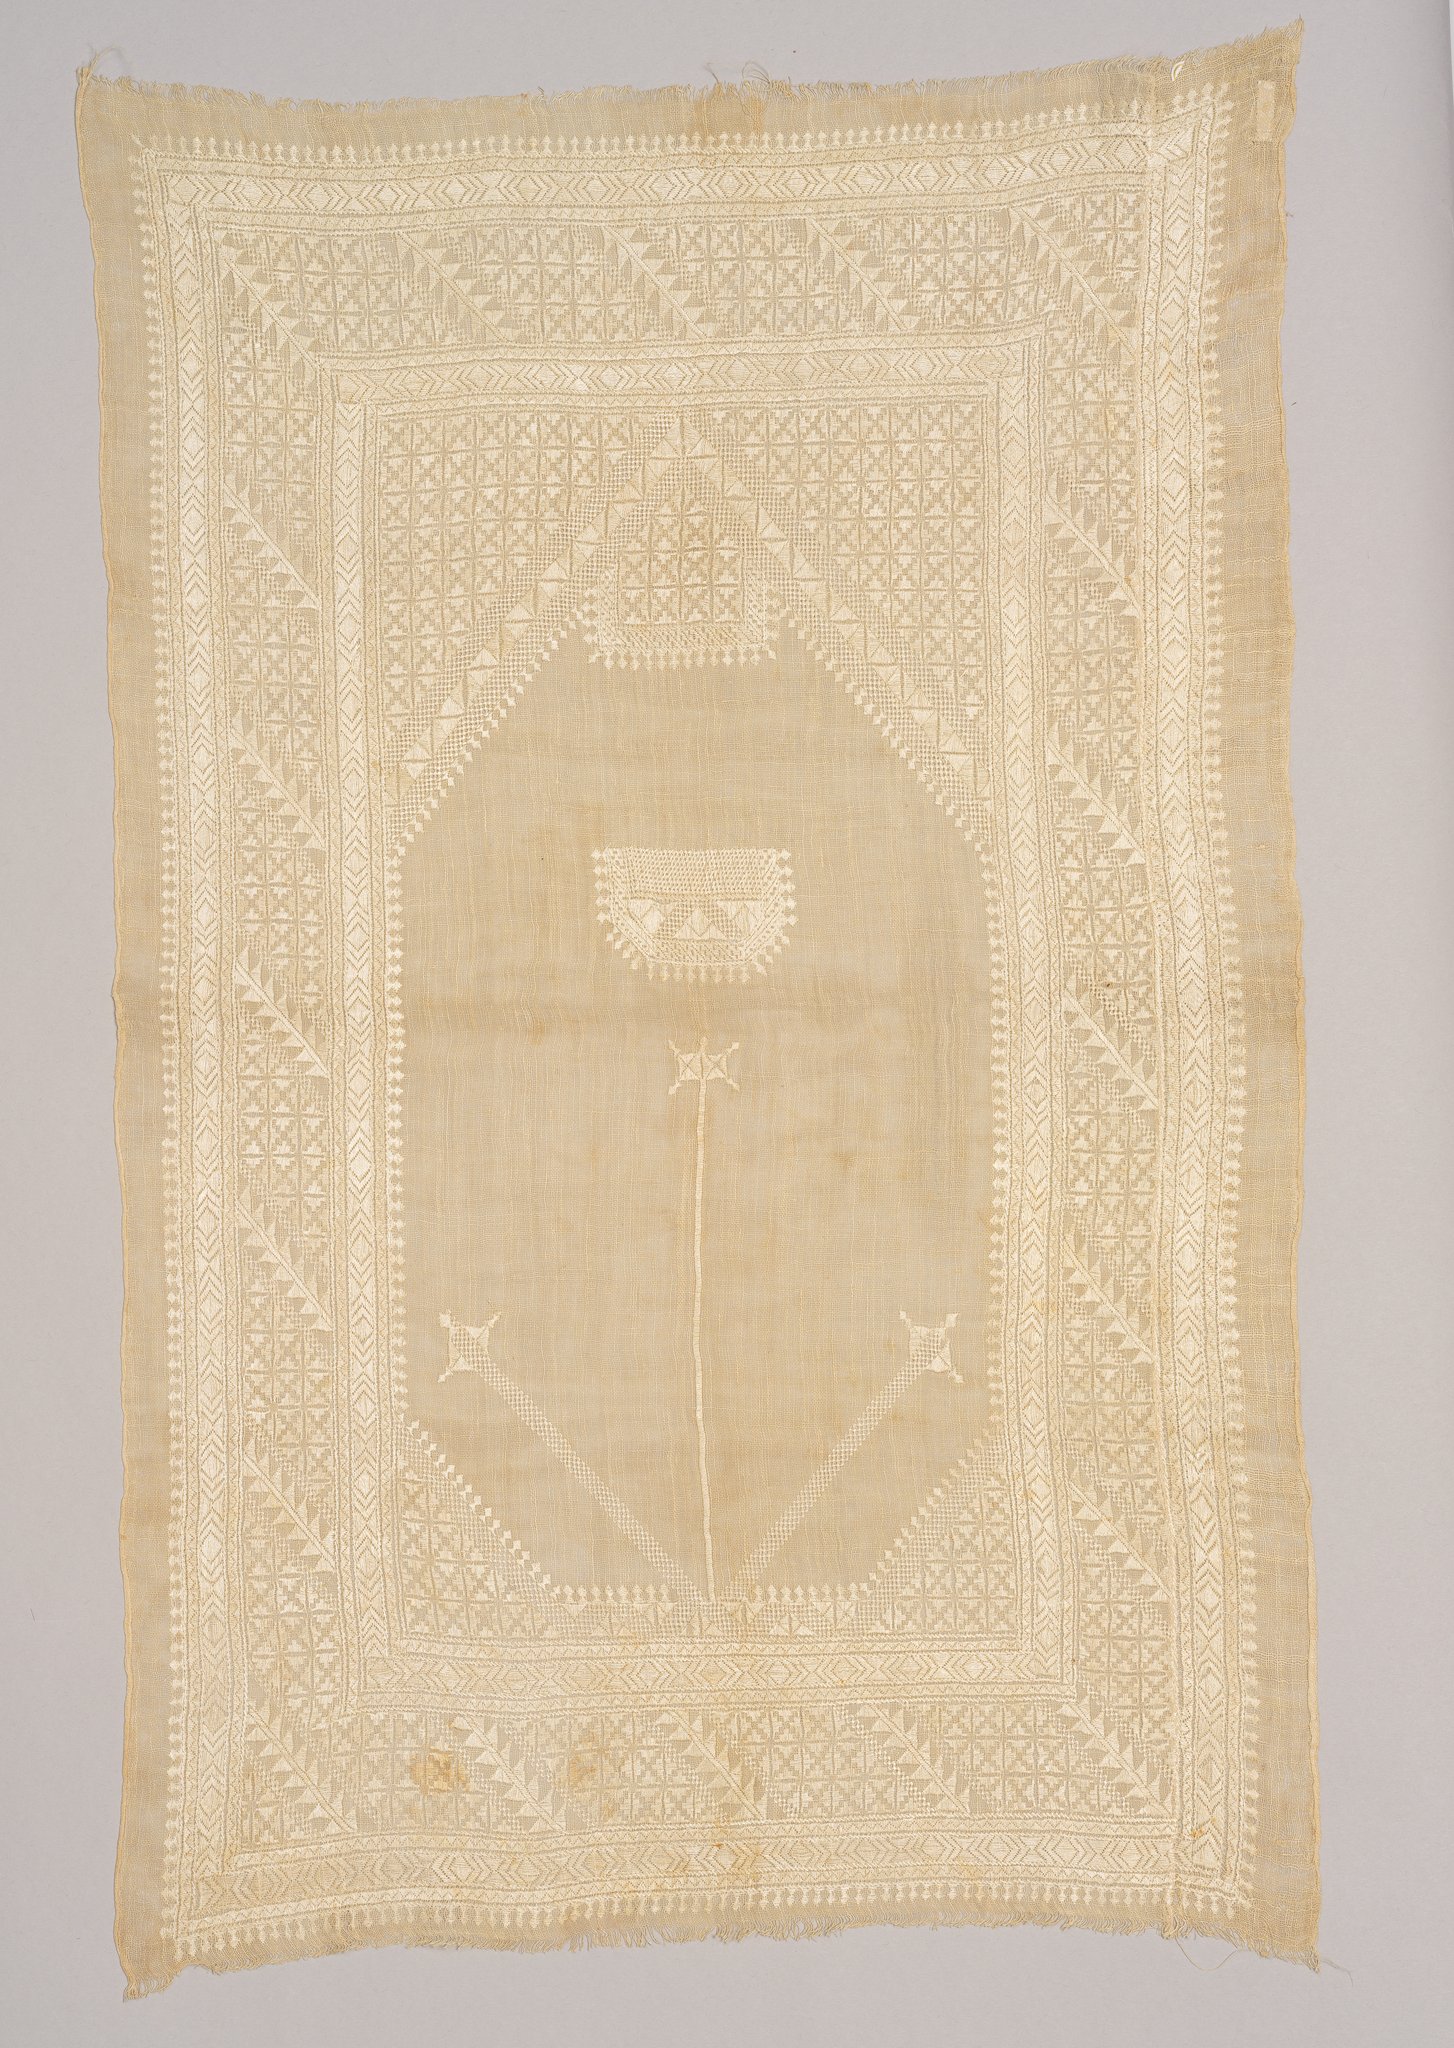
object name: hanging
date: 1701-1800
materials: linen, silk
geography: iran